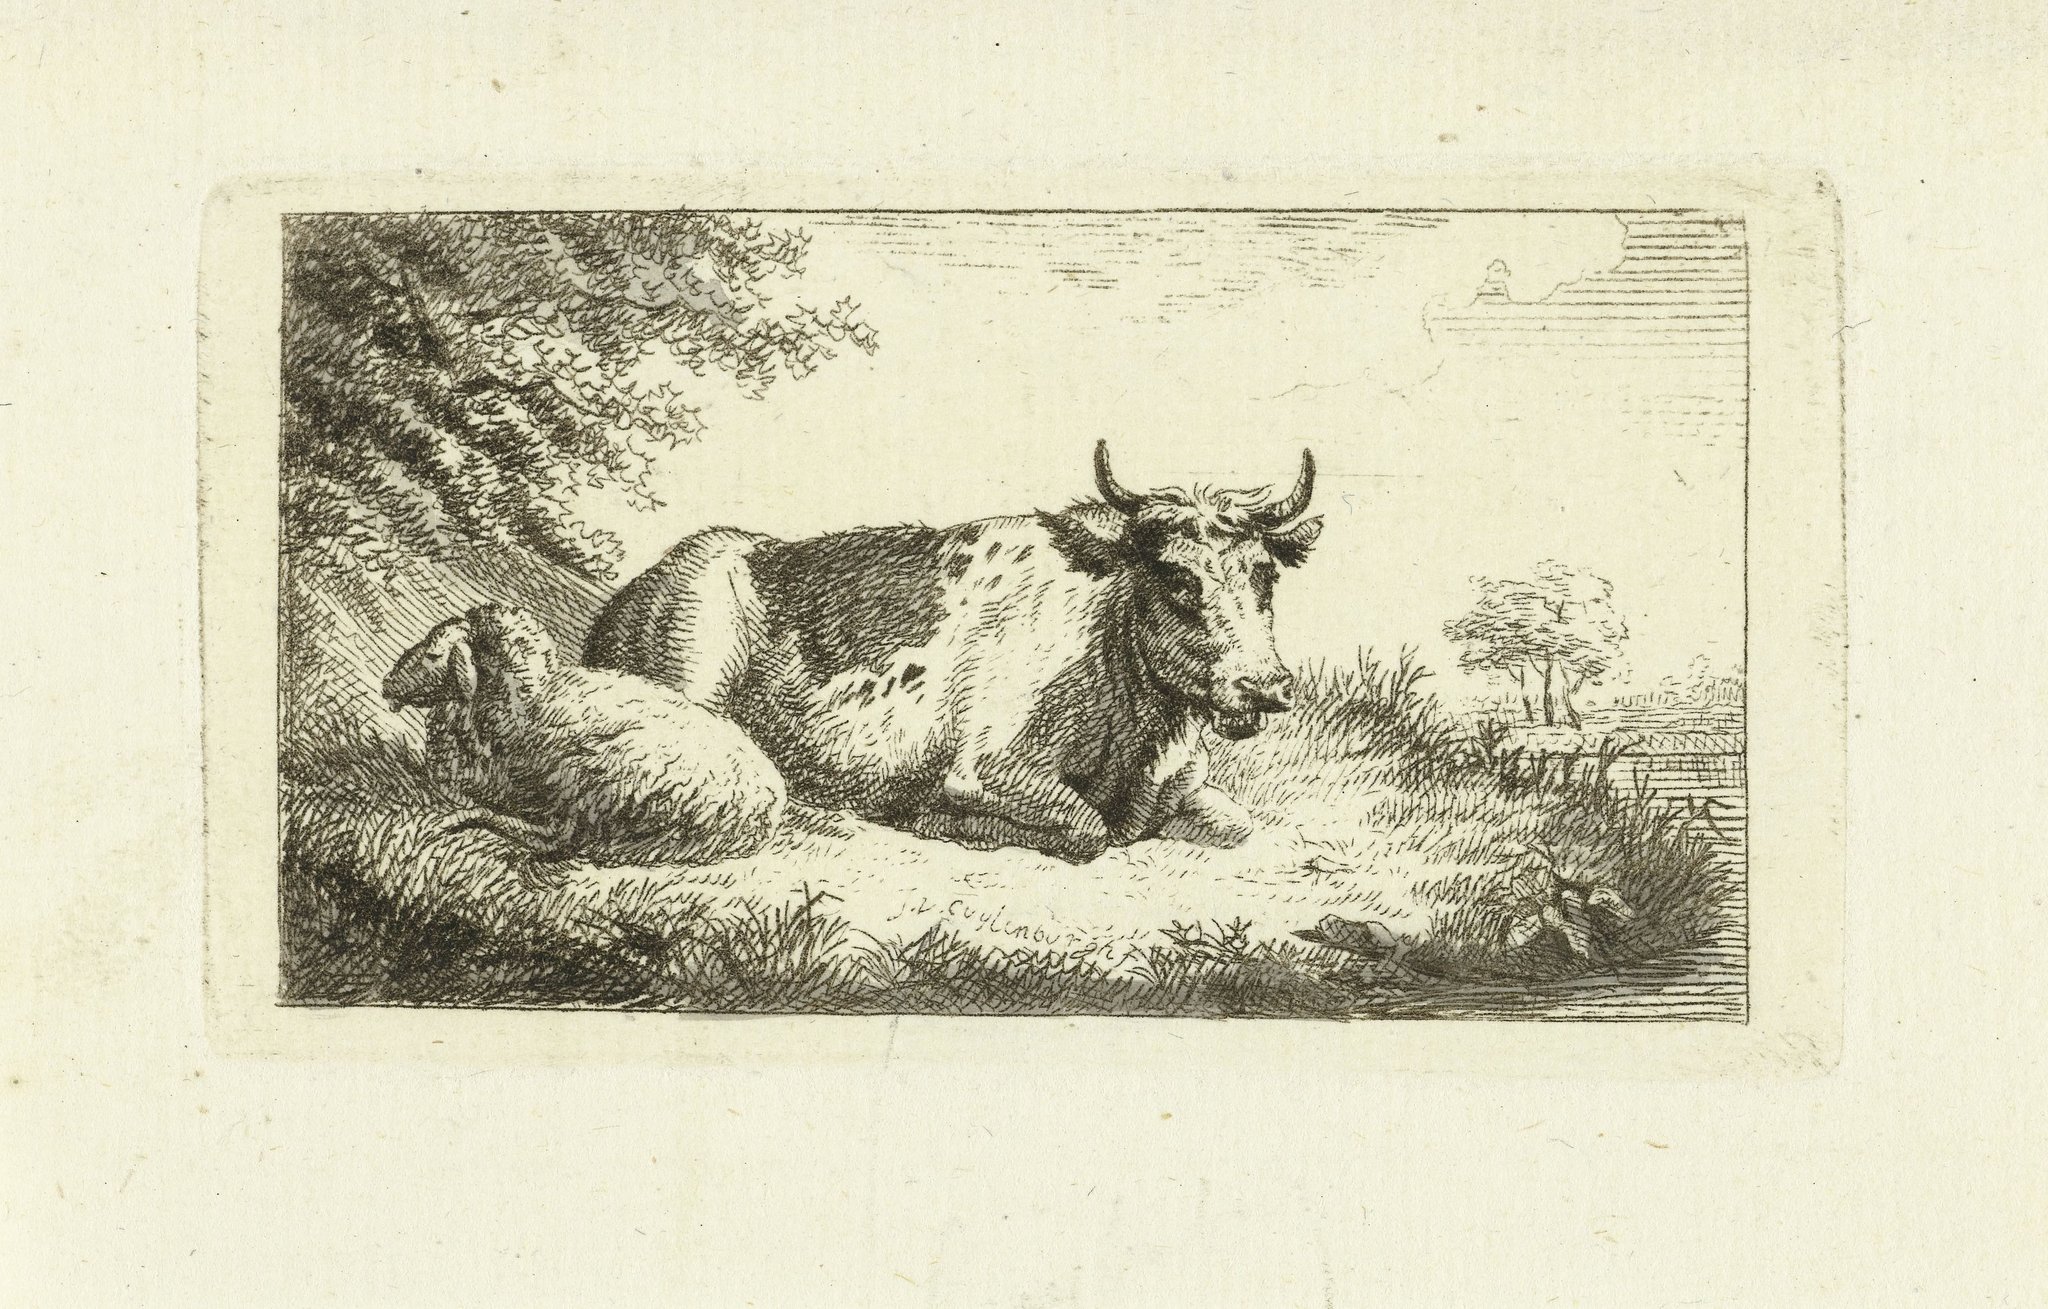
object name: print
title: Liggende koe en schaap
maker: johannes van cuylenburgh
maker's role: print maker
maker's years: 1793-1841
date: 1803-1841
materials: paper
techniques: etching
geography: netherlands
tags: cow, sheep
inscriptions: collector's mark: Lugt 2228